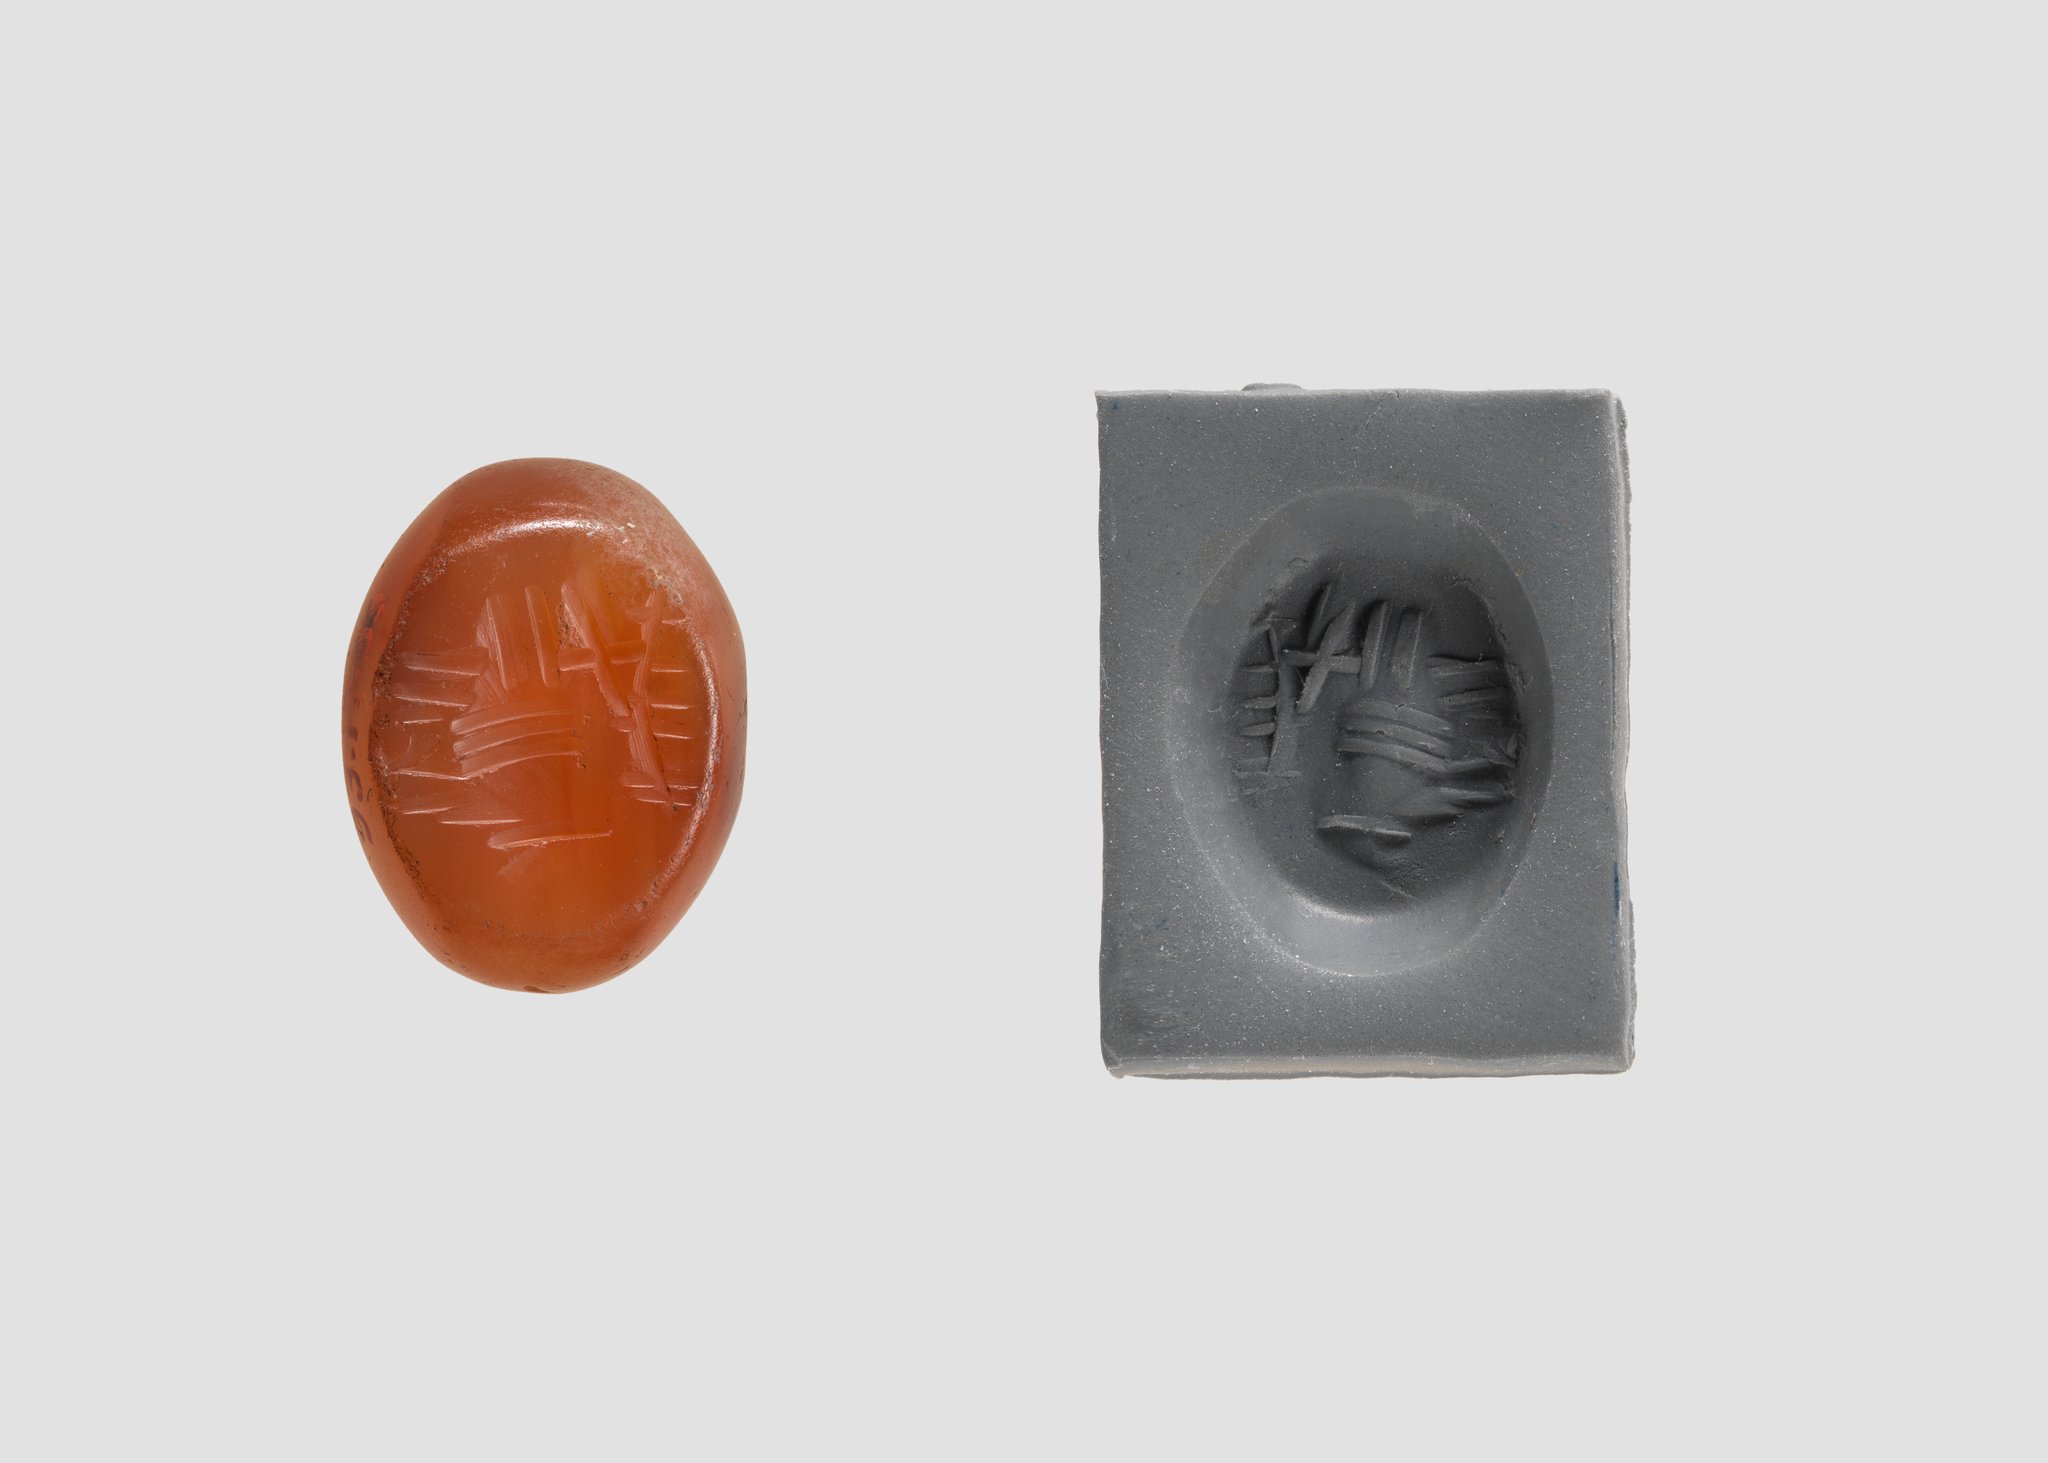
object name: stamp seal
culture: sasanian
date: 201-700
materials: stone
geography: iran or mesopotamia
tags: animals